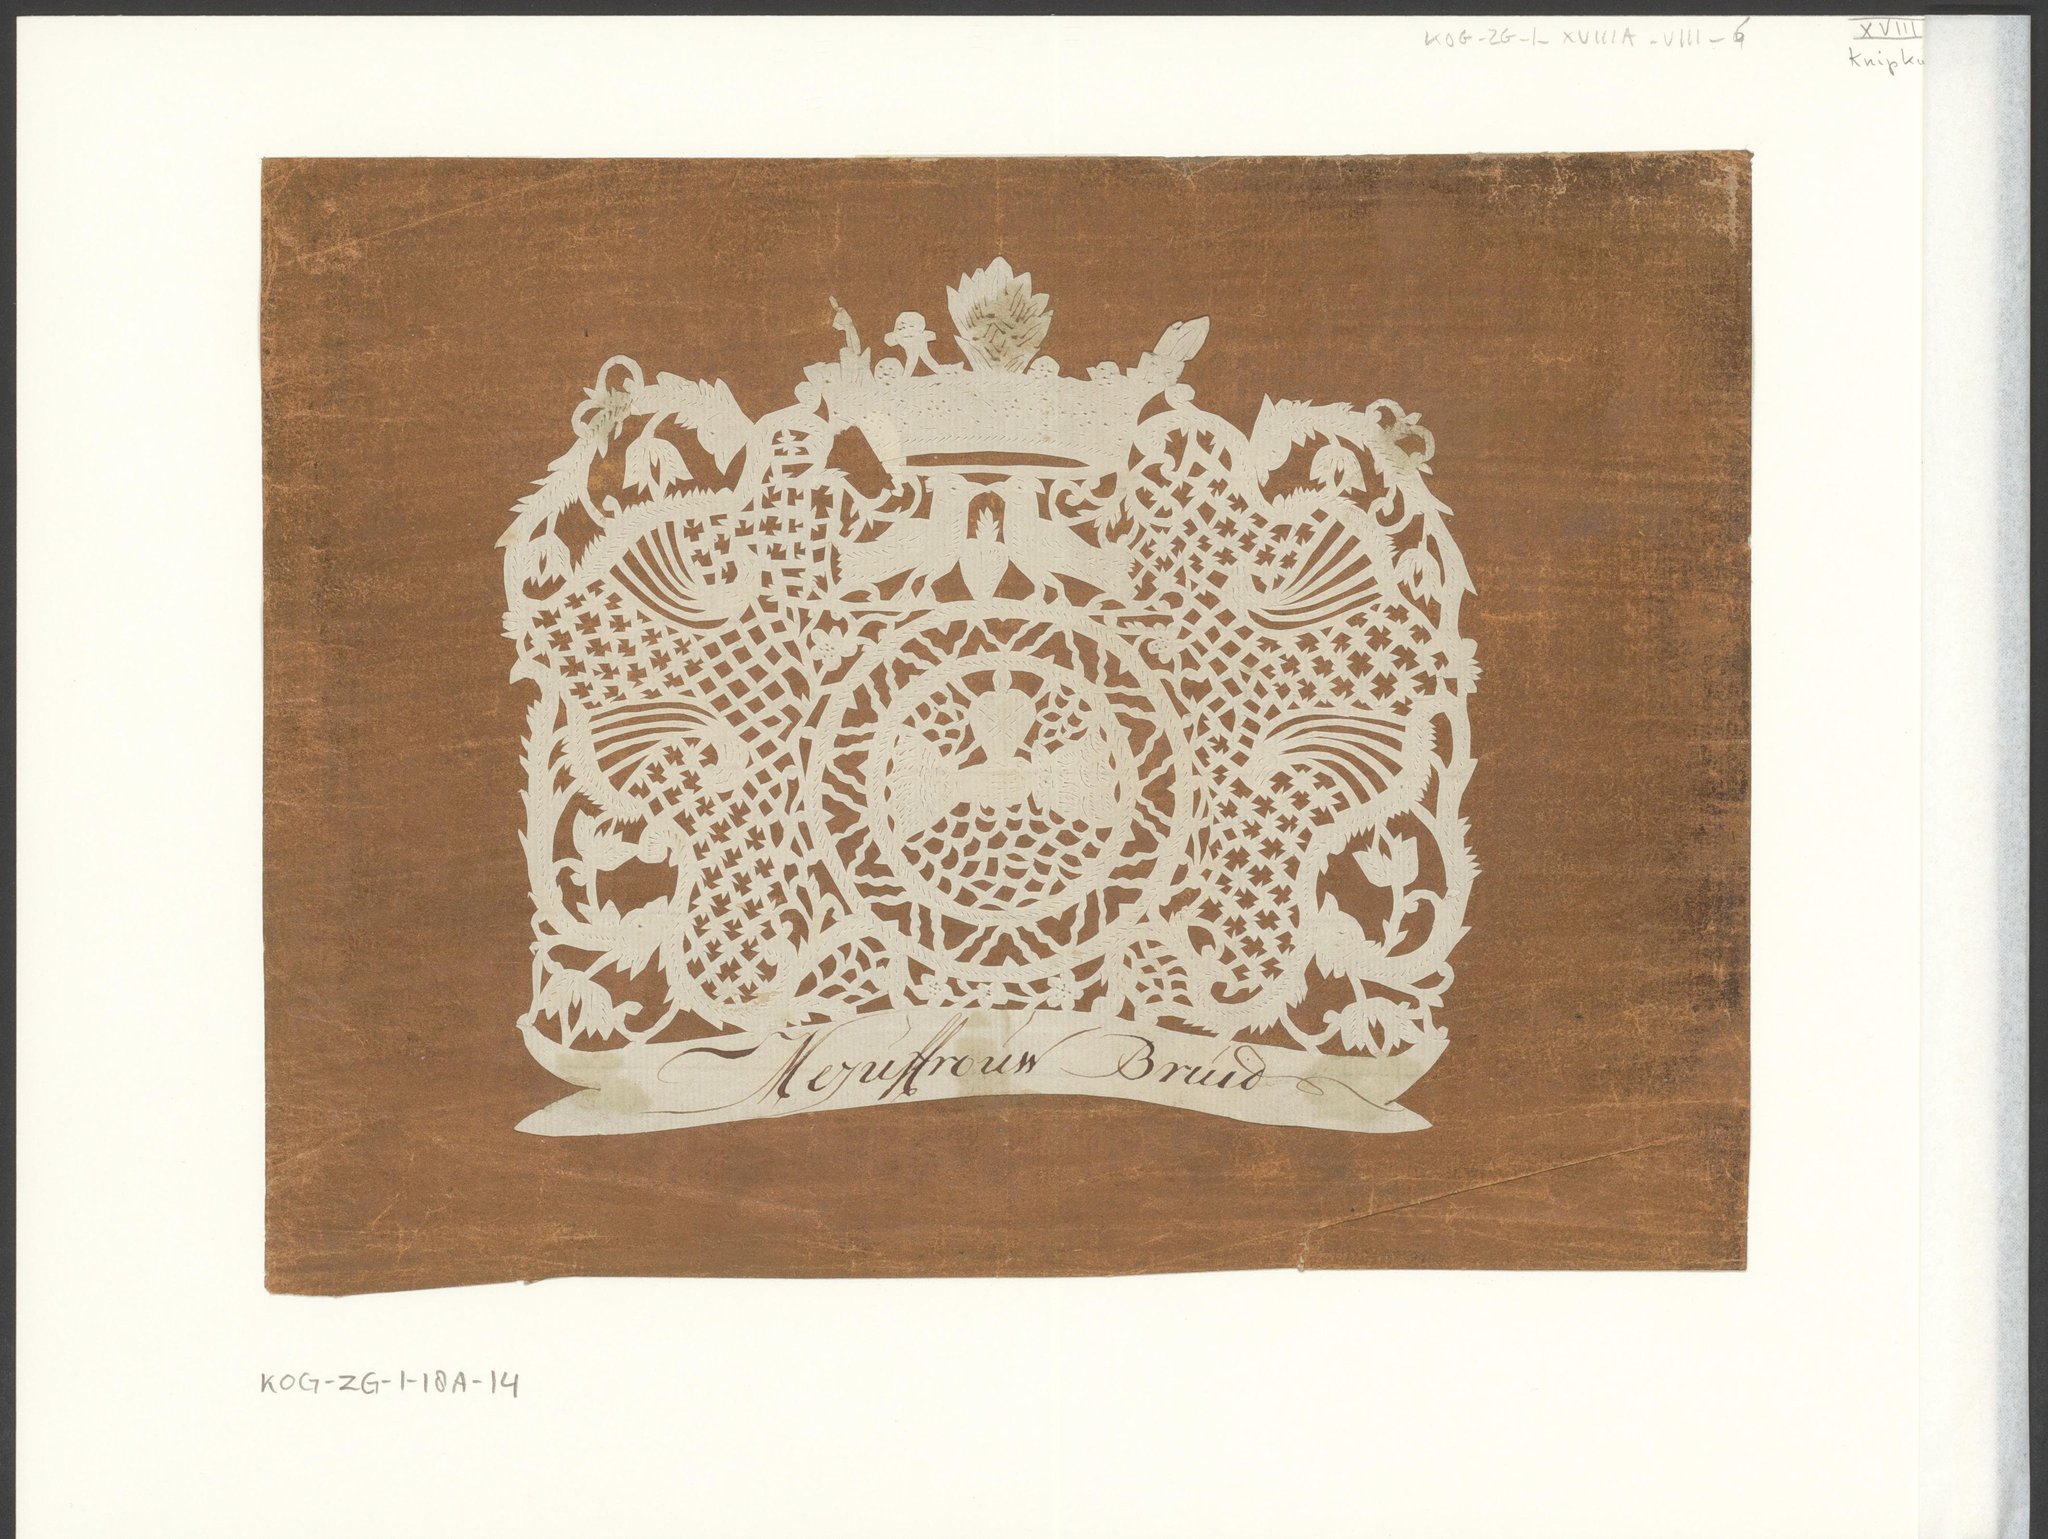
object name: cut paper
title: Huwelijksknipsel met twee in elkaar geslagen handen en vogels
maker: Anonymous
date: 1750-1849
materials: ink, paper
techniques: pen, snipping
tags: flowers, marriage, married couple, 'matrimonium'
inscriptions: collector's mark: Lugt 1641, stamp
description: Plaatsaanduiding voor maaltijd met twee in elkaar geslagen handen en vogels. Daarboven een brandend hart tussen twee duiven en daarboven een kroon. Onderaan de tekst: Mejuffrouw Bruid. Onderwerpsrubrieken binnen de Atlas Zeden en Gewoonten: Schoone kunsten, Knipkunst.